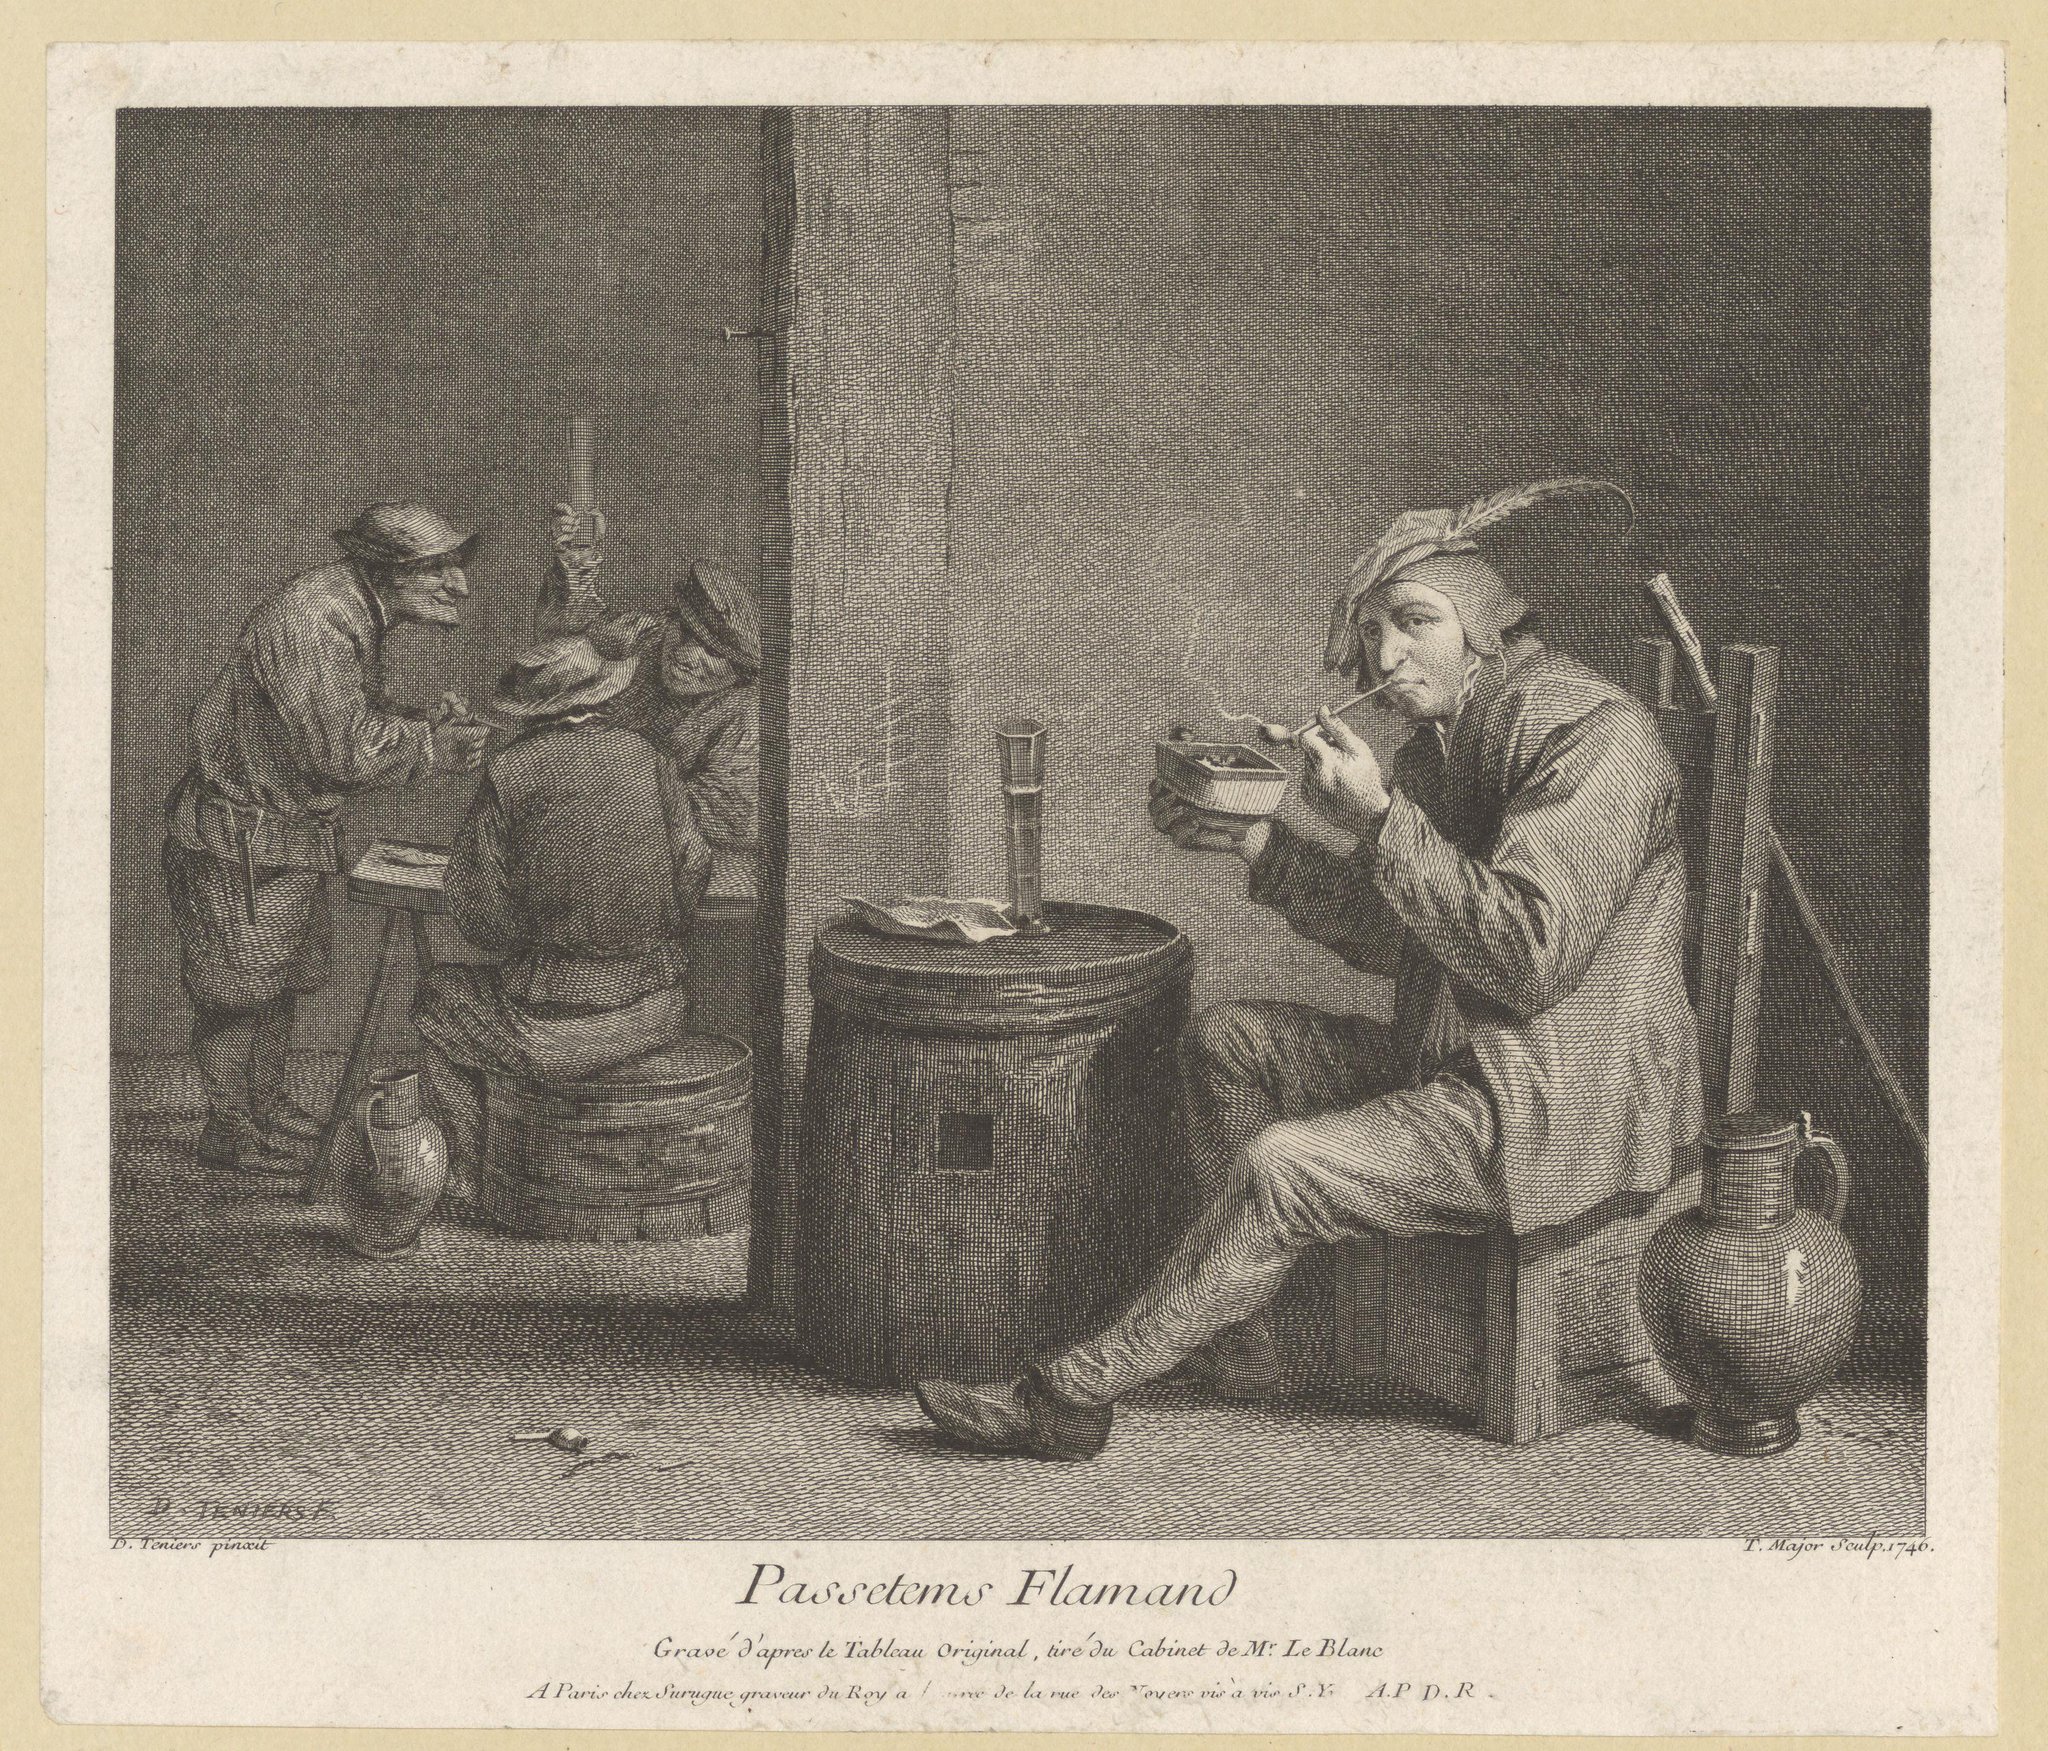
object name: print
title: Rokende en drinkende mannen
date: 1746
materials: paper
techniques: etching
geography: paris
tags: inn, coffee-house, public house, etc., drinks, stimulants, drugs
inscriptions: collector's mark: Lugt 240